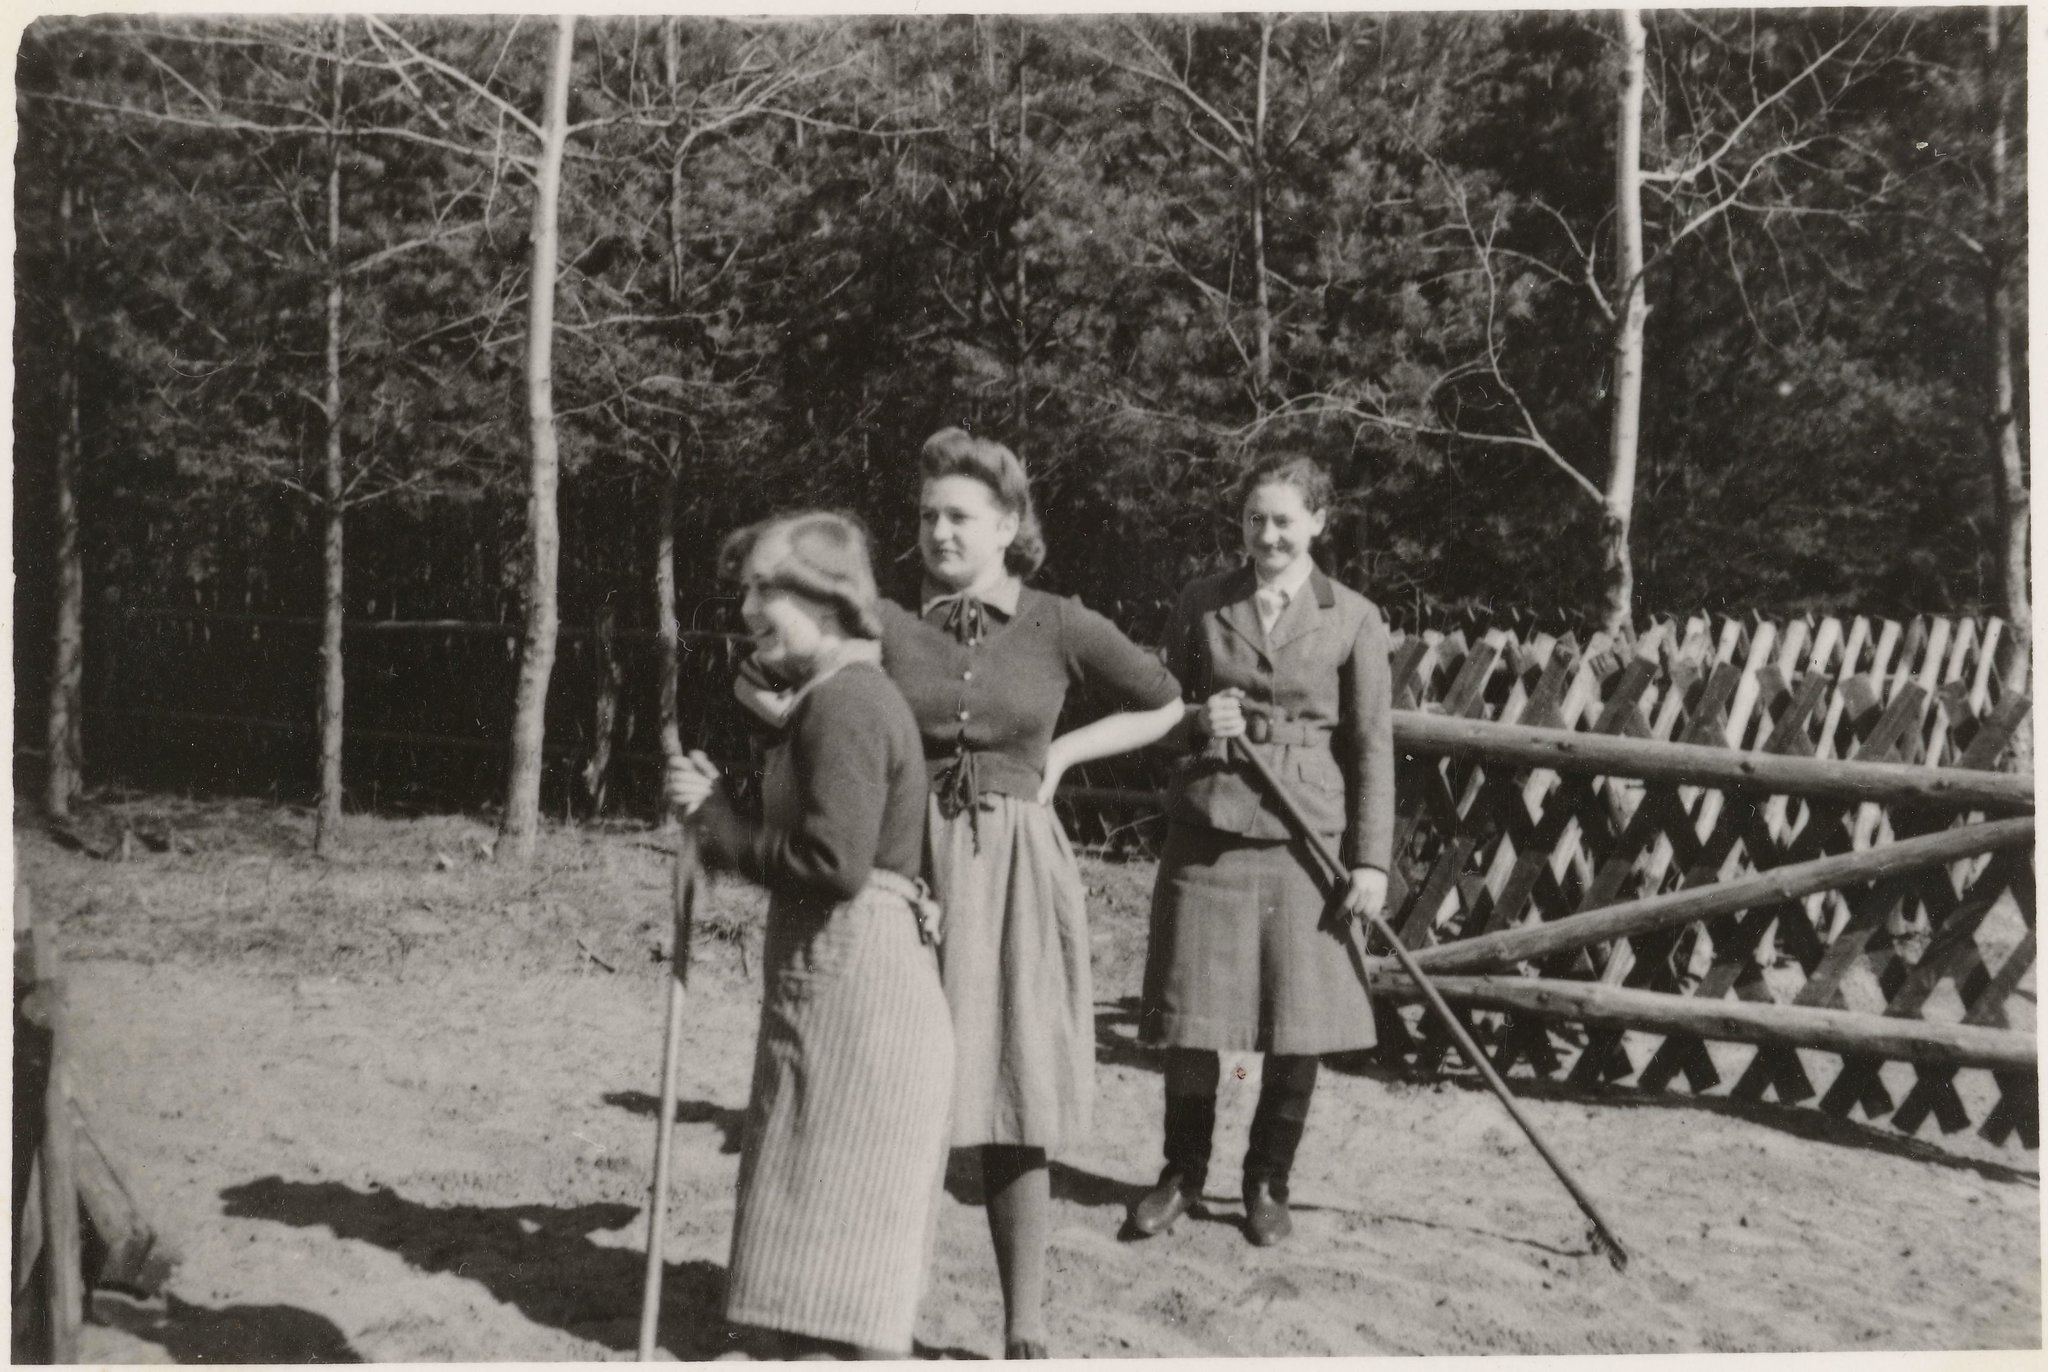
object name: photograph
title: Drie vrouwen met harken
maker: Anonymous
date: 1940-1945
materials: photographic support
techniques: gelatin silver print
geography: czechoslovakia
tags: netherlands, germany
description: Drie vrouwen met harken, op de achtergrond een hek en bomen. Foto behorend bij album 'Kriegserinnerungen'.